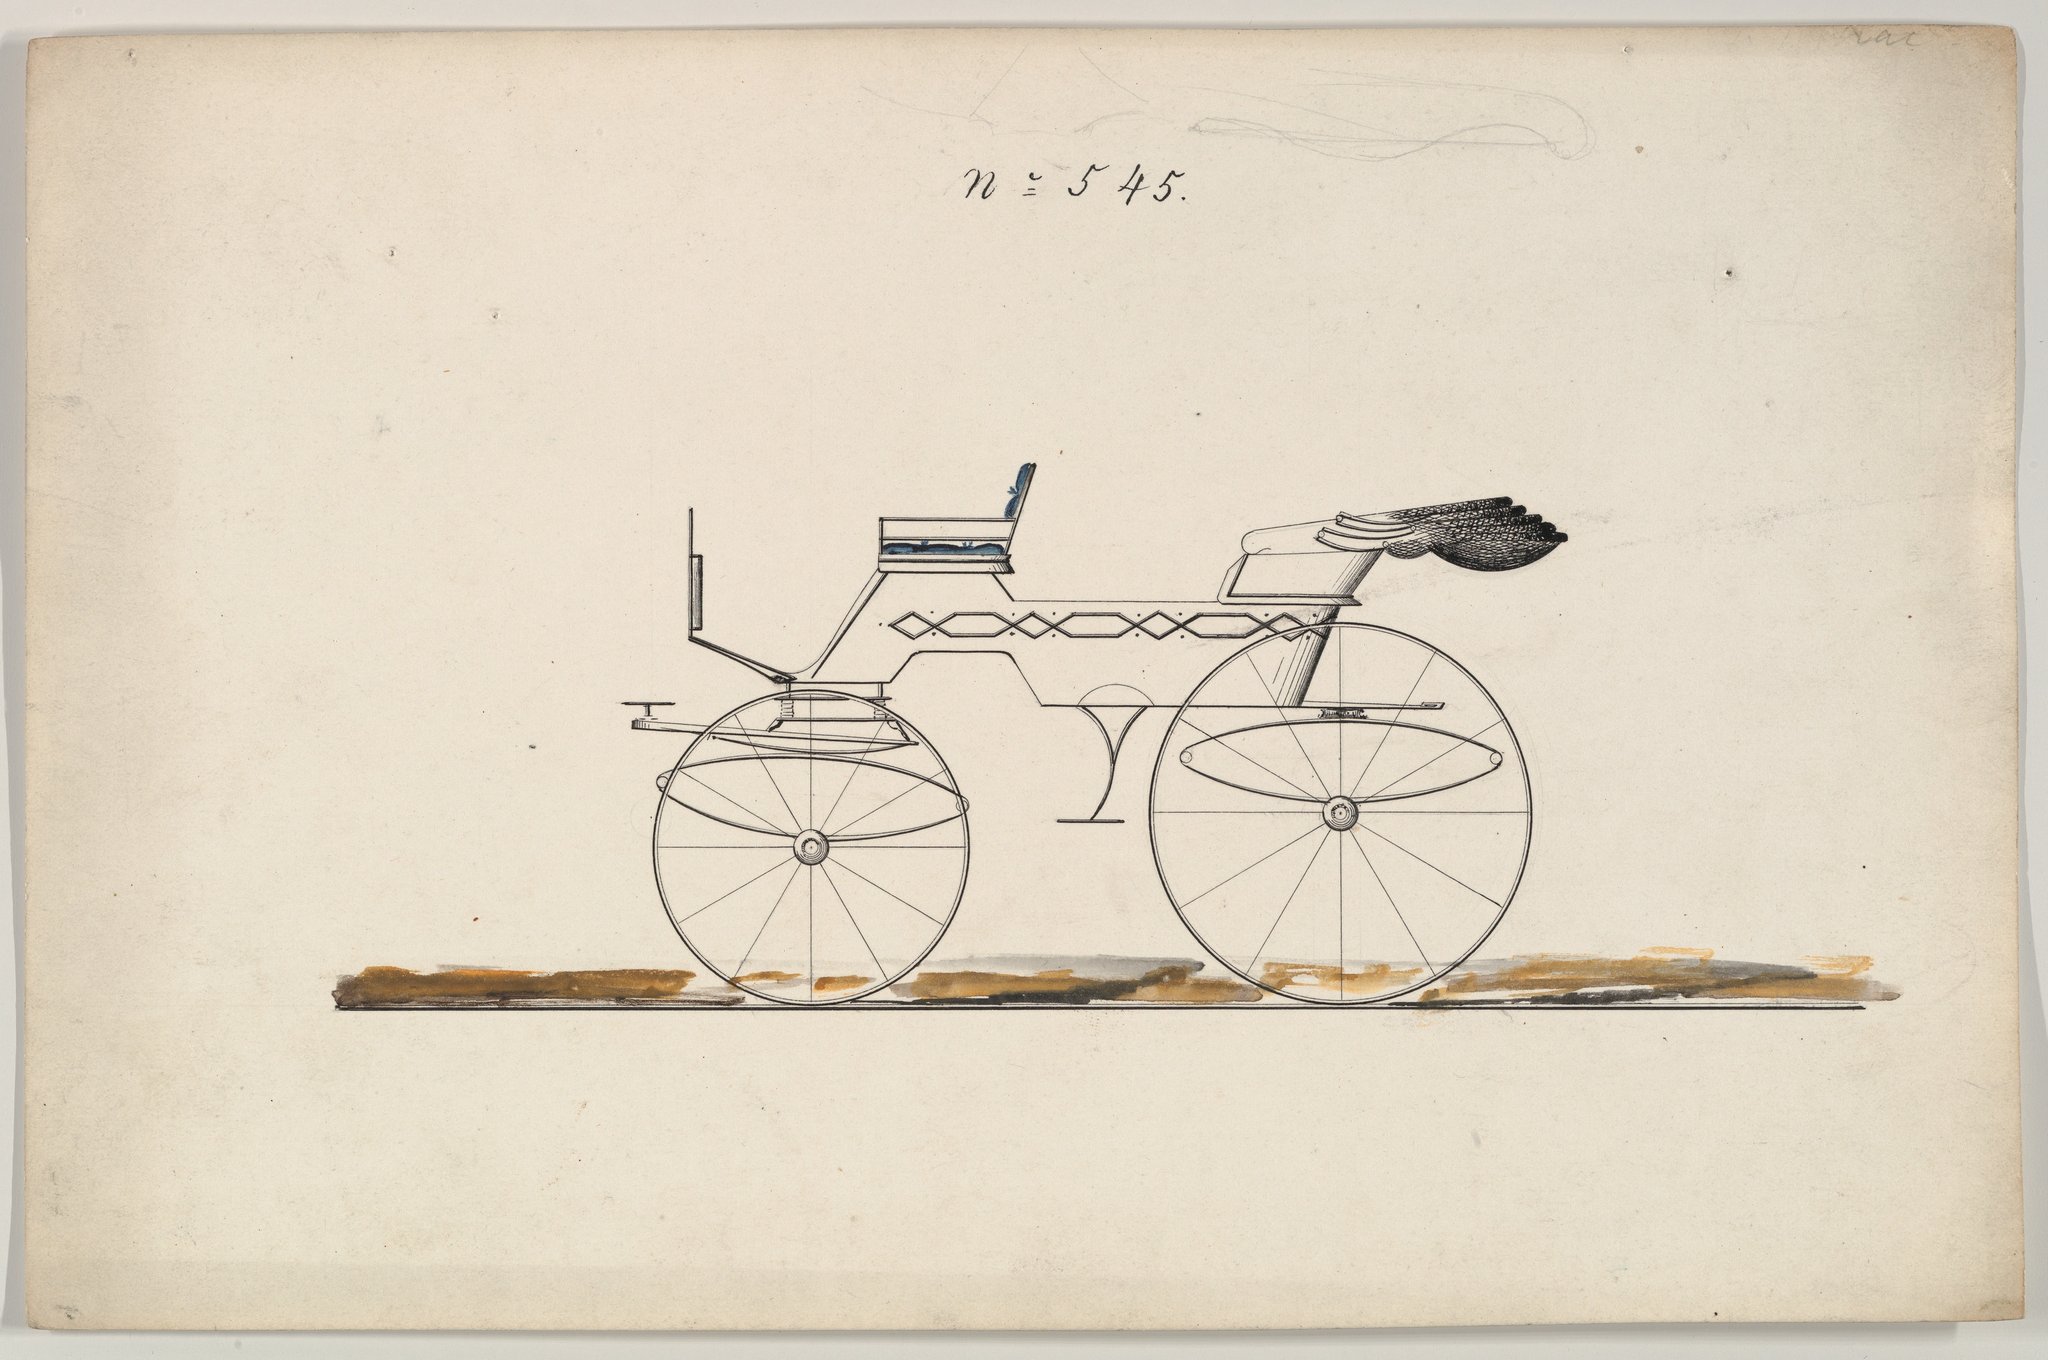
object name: drawing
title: Design for Phaeton, no. 545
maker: brewster & co.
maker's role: manufacturer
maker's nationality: american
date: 1850-1874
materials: gouache, ink, watercolor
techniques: pen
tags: carriages